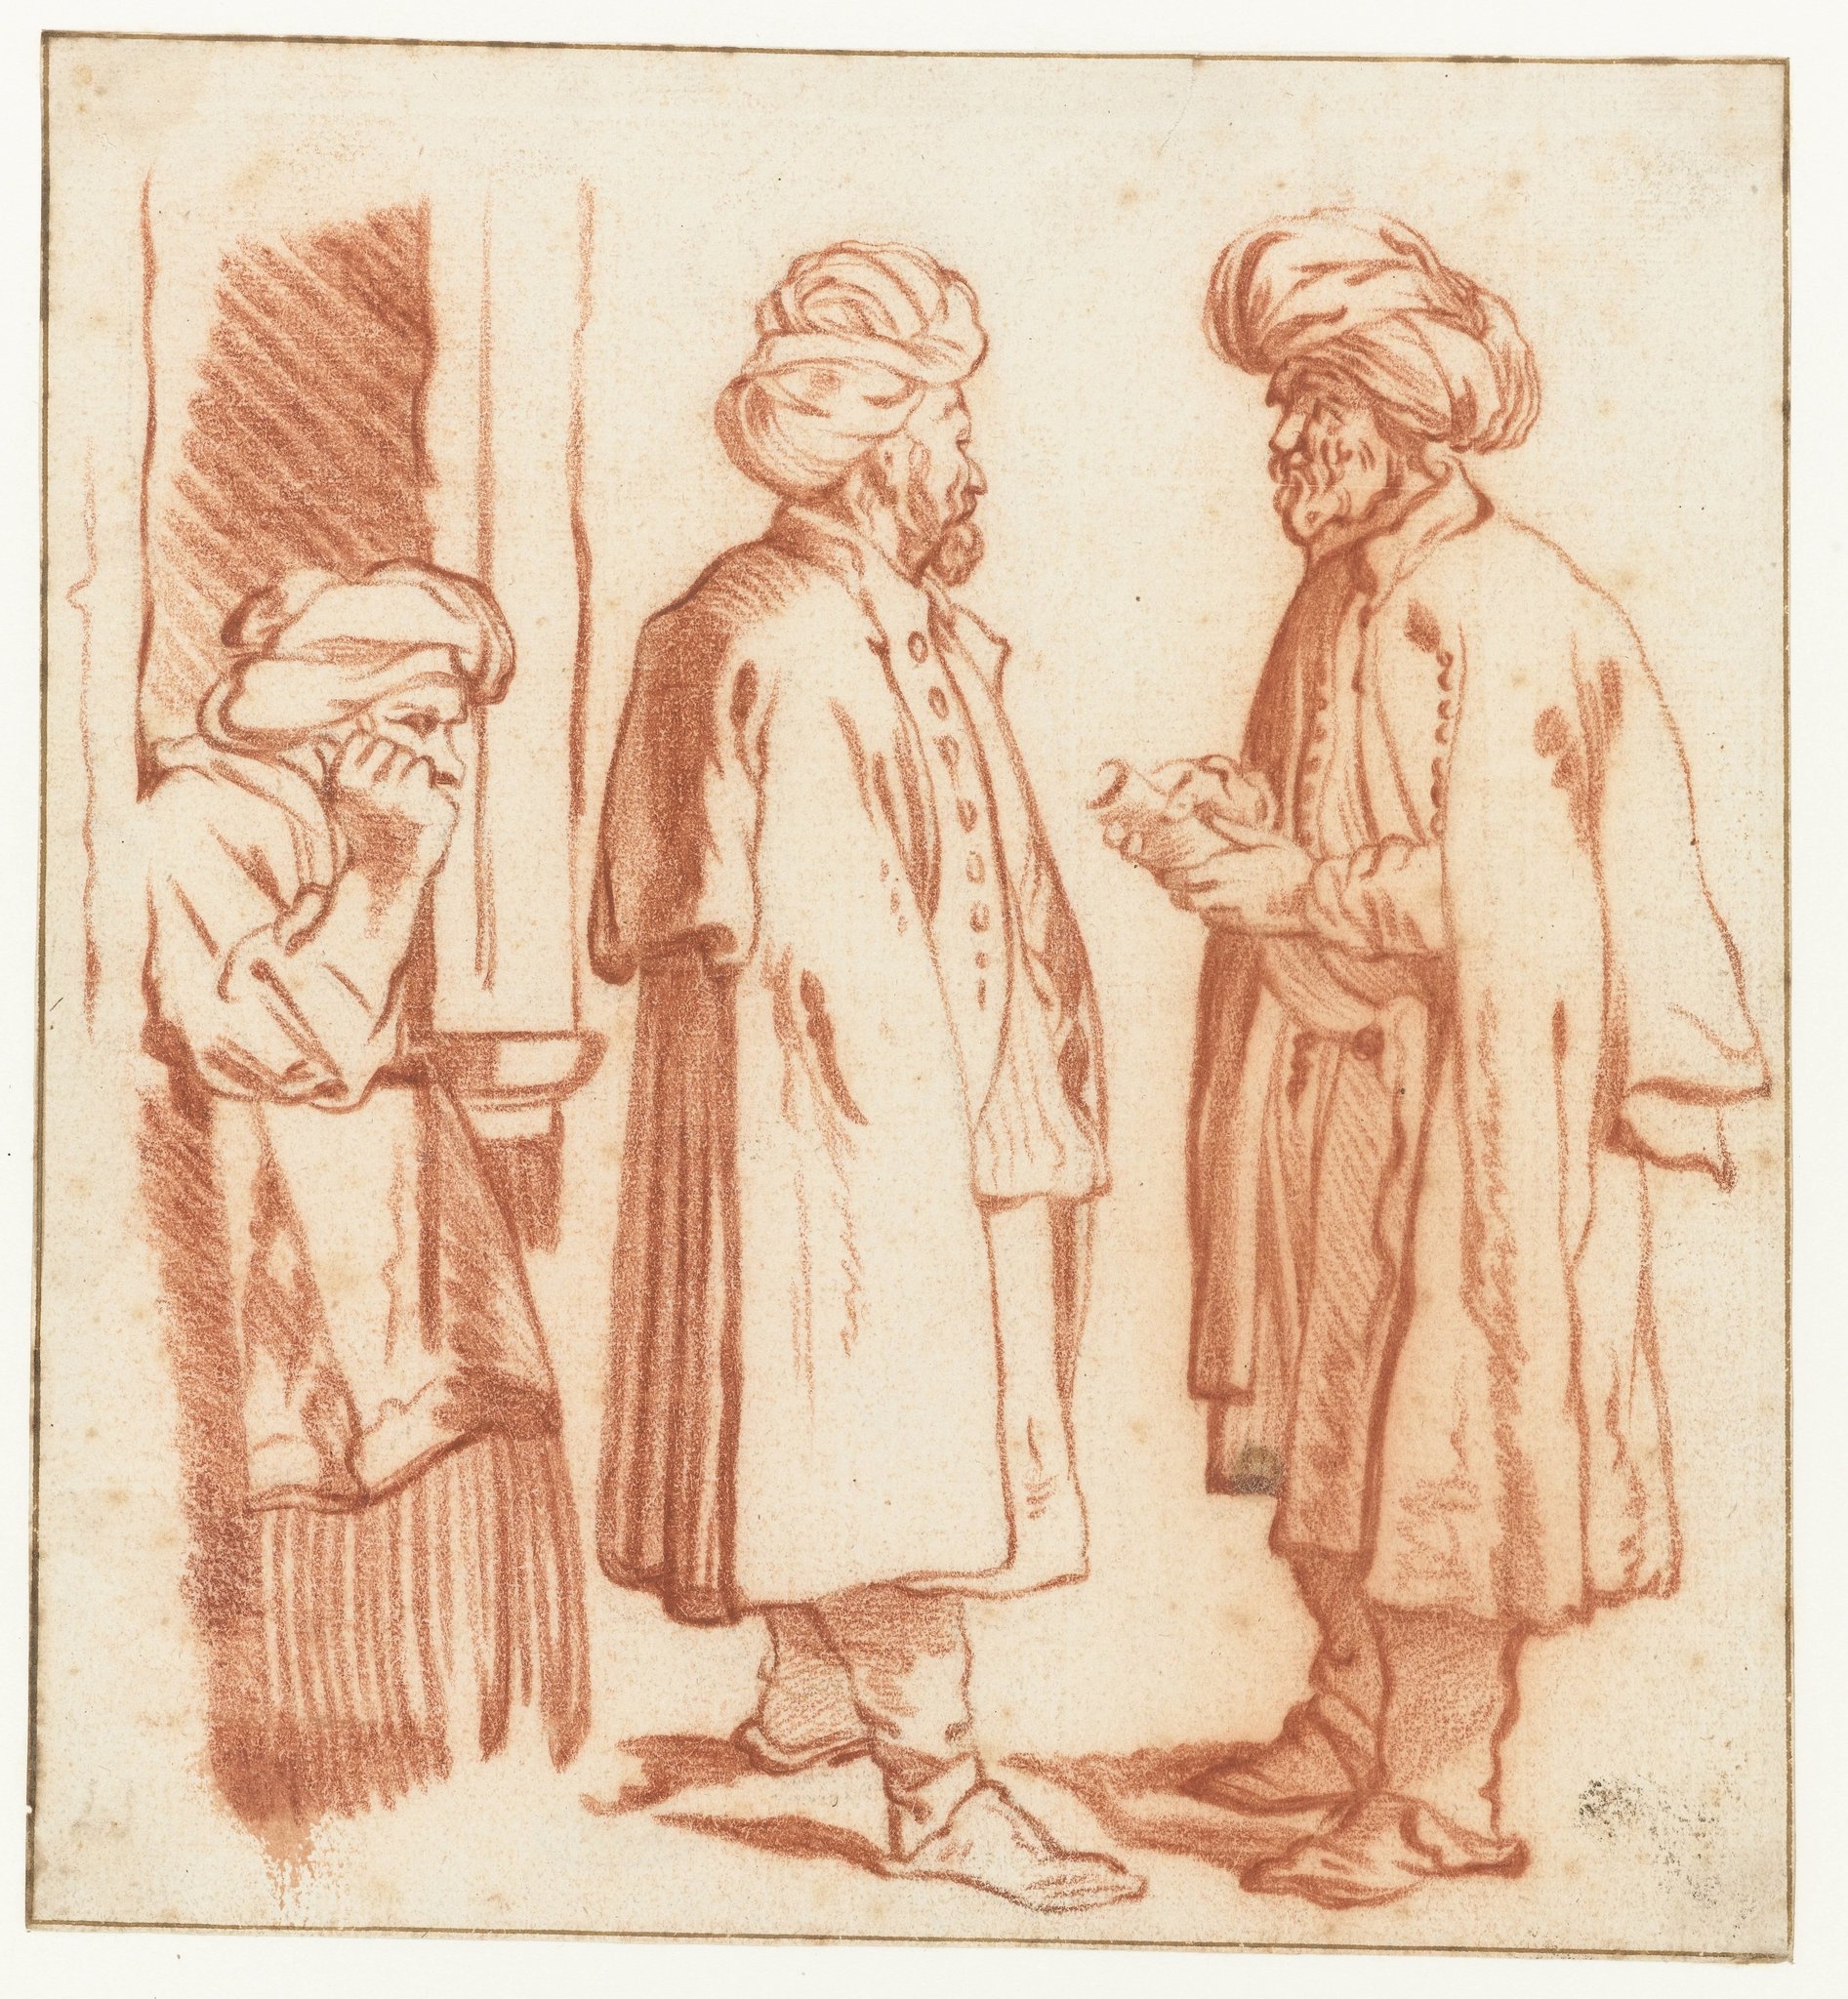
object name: drawing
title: Drie Oosterlingen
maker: pieter lastman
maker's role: draughtsman, painter, print maker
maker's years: 1583-1633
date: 1631-1674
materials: chalk, paper